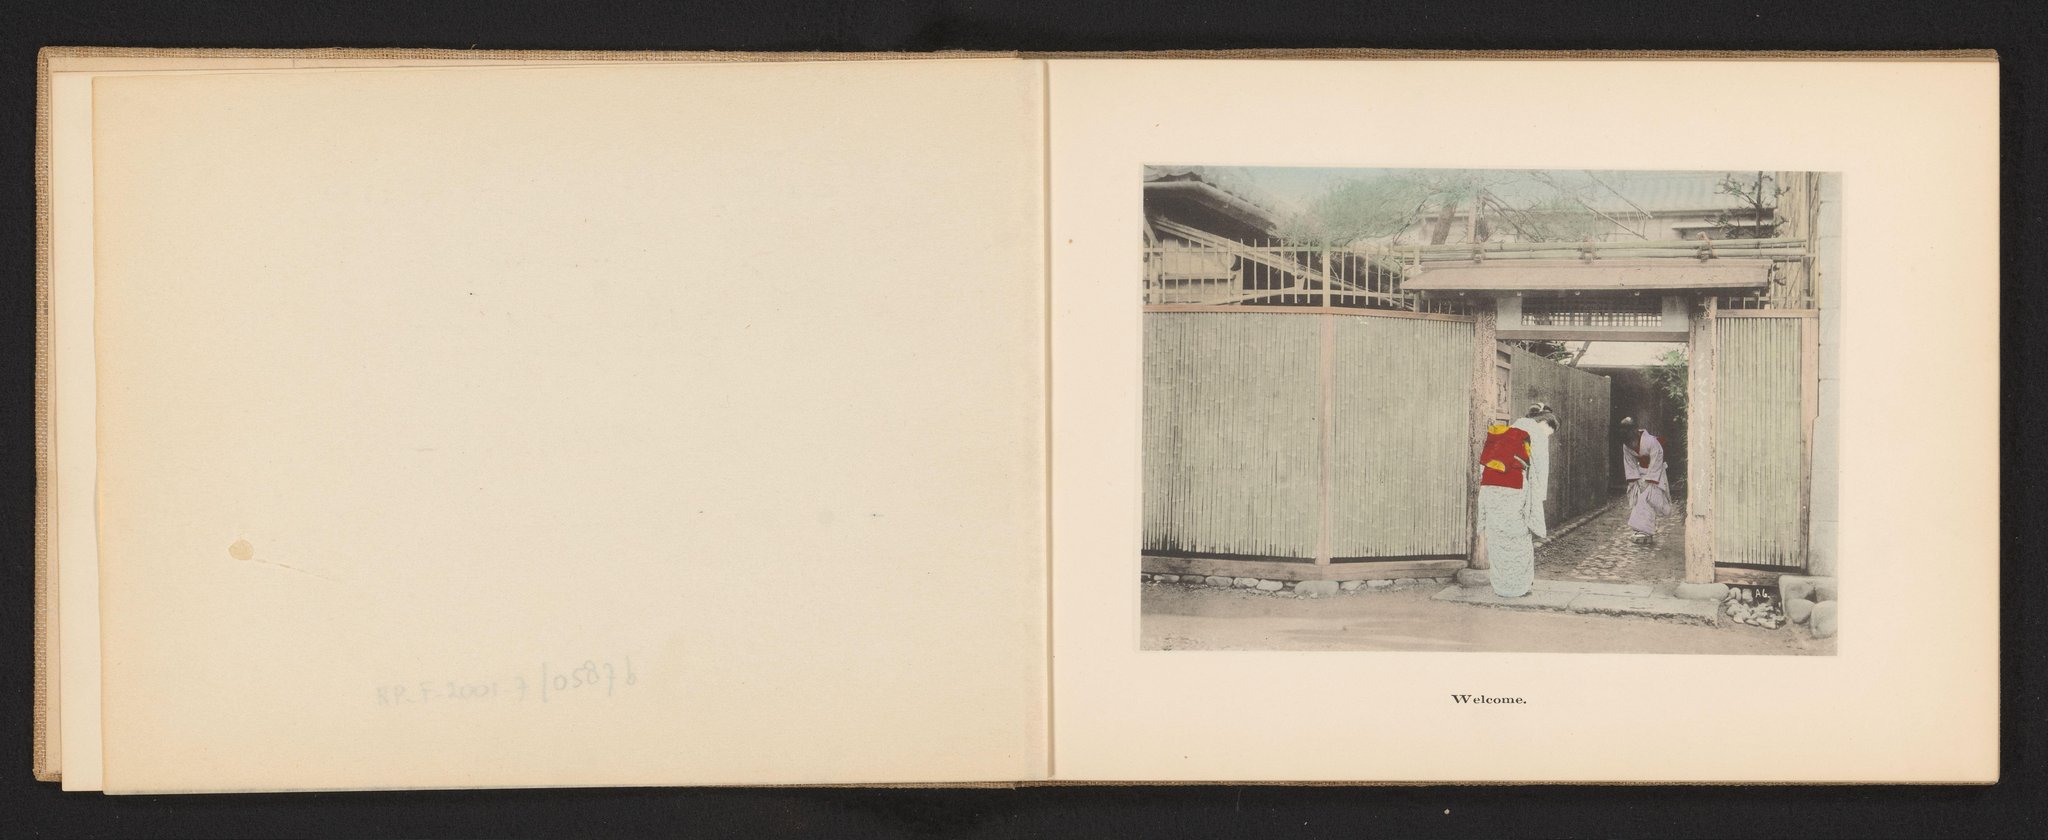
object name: page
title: Twee vrouwen in traditionele Japanse kleding die elkaar begroeten bij een poort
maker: kōzaburō tamamura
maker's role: fotograaf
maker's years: 1856-1923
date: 1895-1905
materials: paper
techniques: photograph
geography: japan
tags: folk costume, regional costume, japan